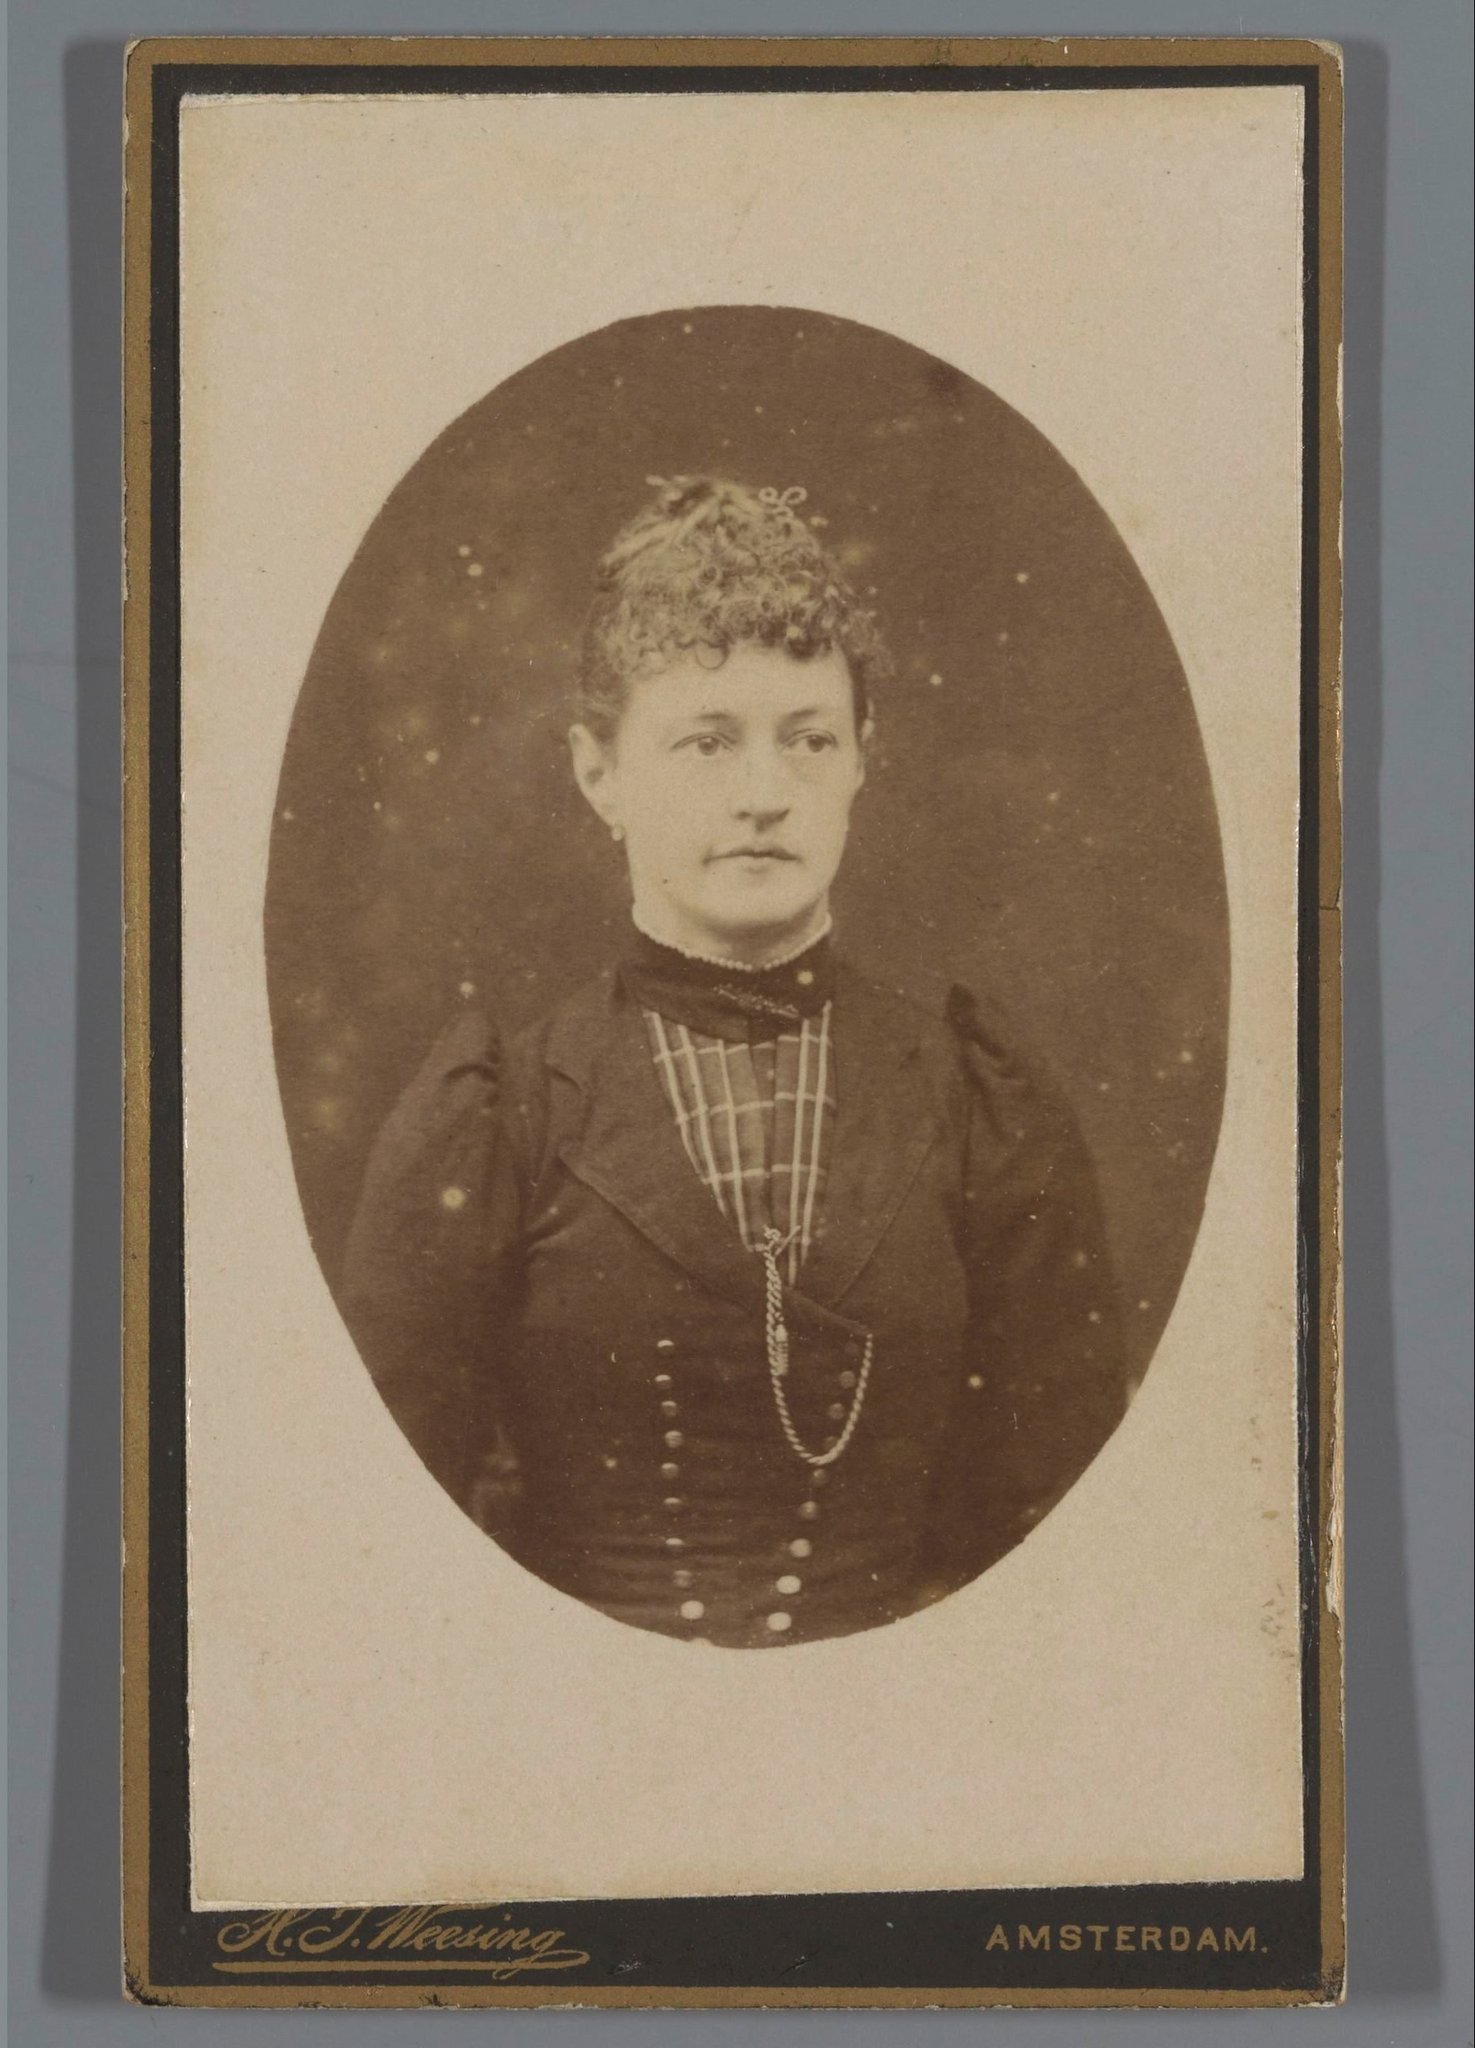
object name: semi enamel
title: Portret van een onbekende vrouw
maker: hermanus jodocus weesing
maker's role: fotograaf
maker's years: 1844-1910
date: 1880-1900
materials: cardboard, celluloid, paper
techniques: albumen print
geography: amsterdam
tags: historical persons - bb - woman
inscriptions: inscription: ‘H. J. Weesing/ PHOTOGRAPHE/ AMSTERDAM Binnen Brouwerstraat 5./ Musterschutz A.L.’